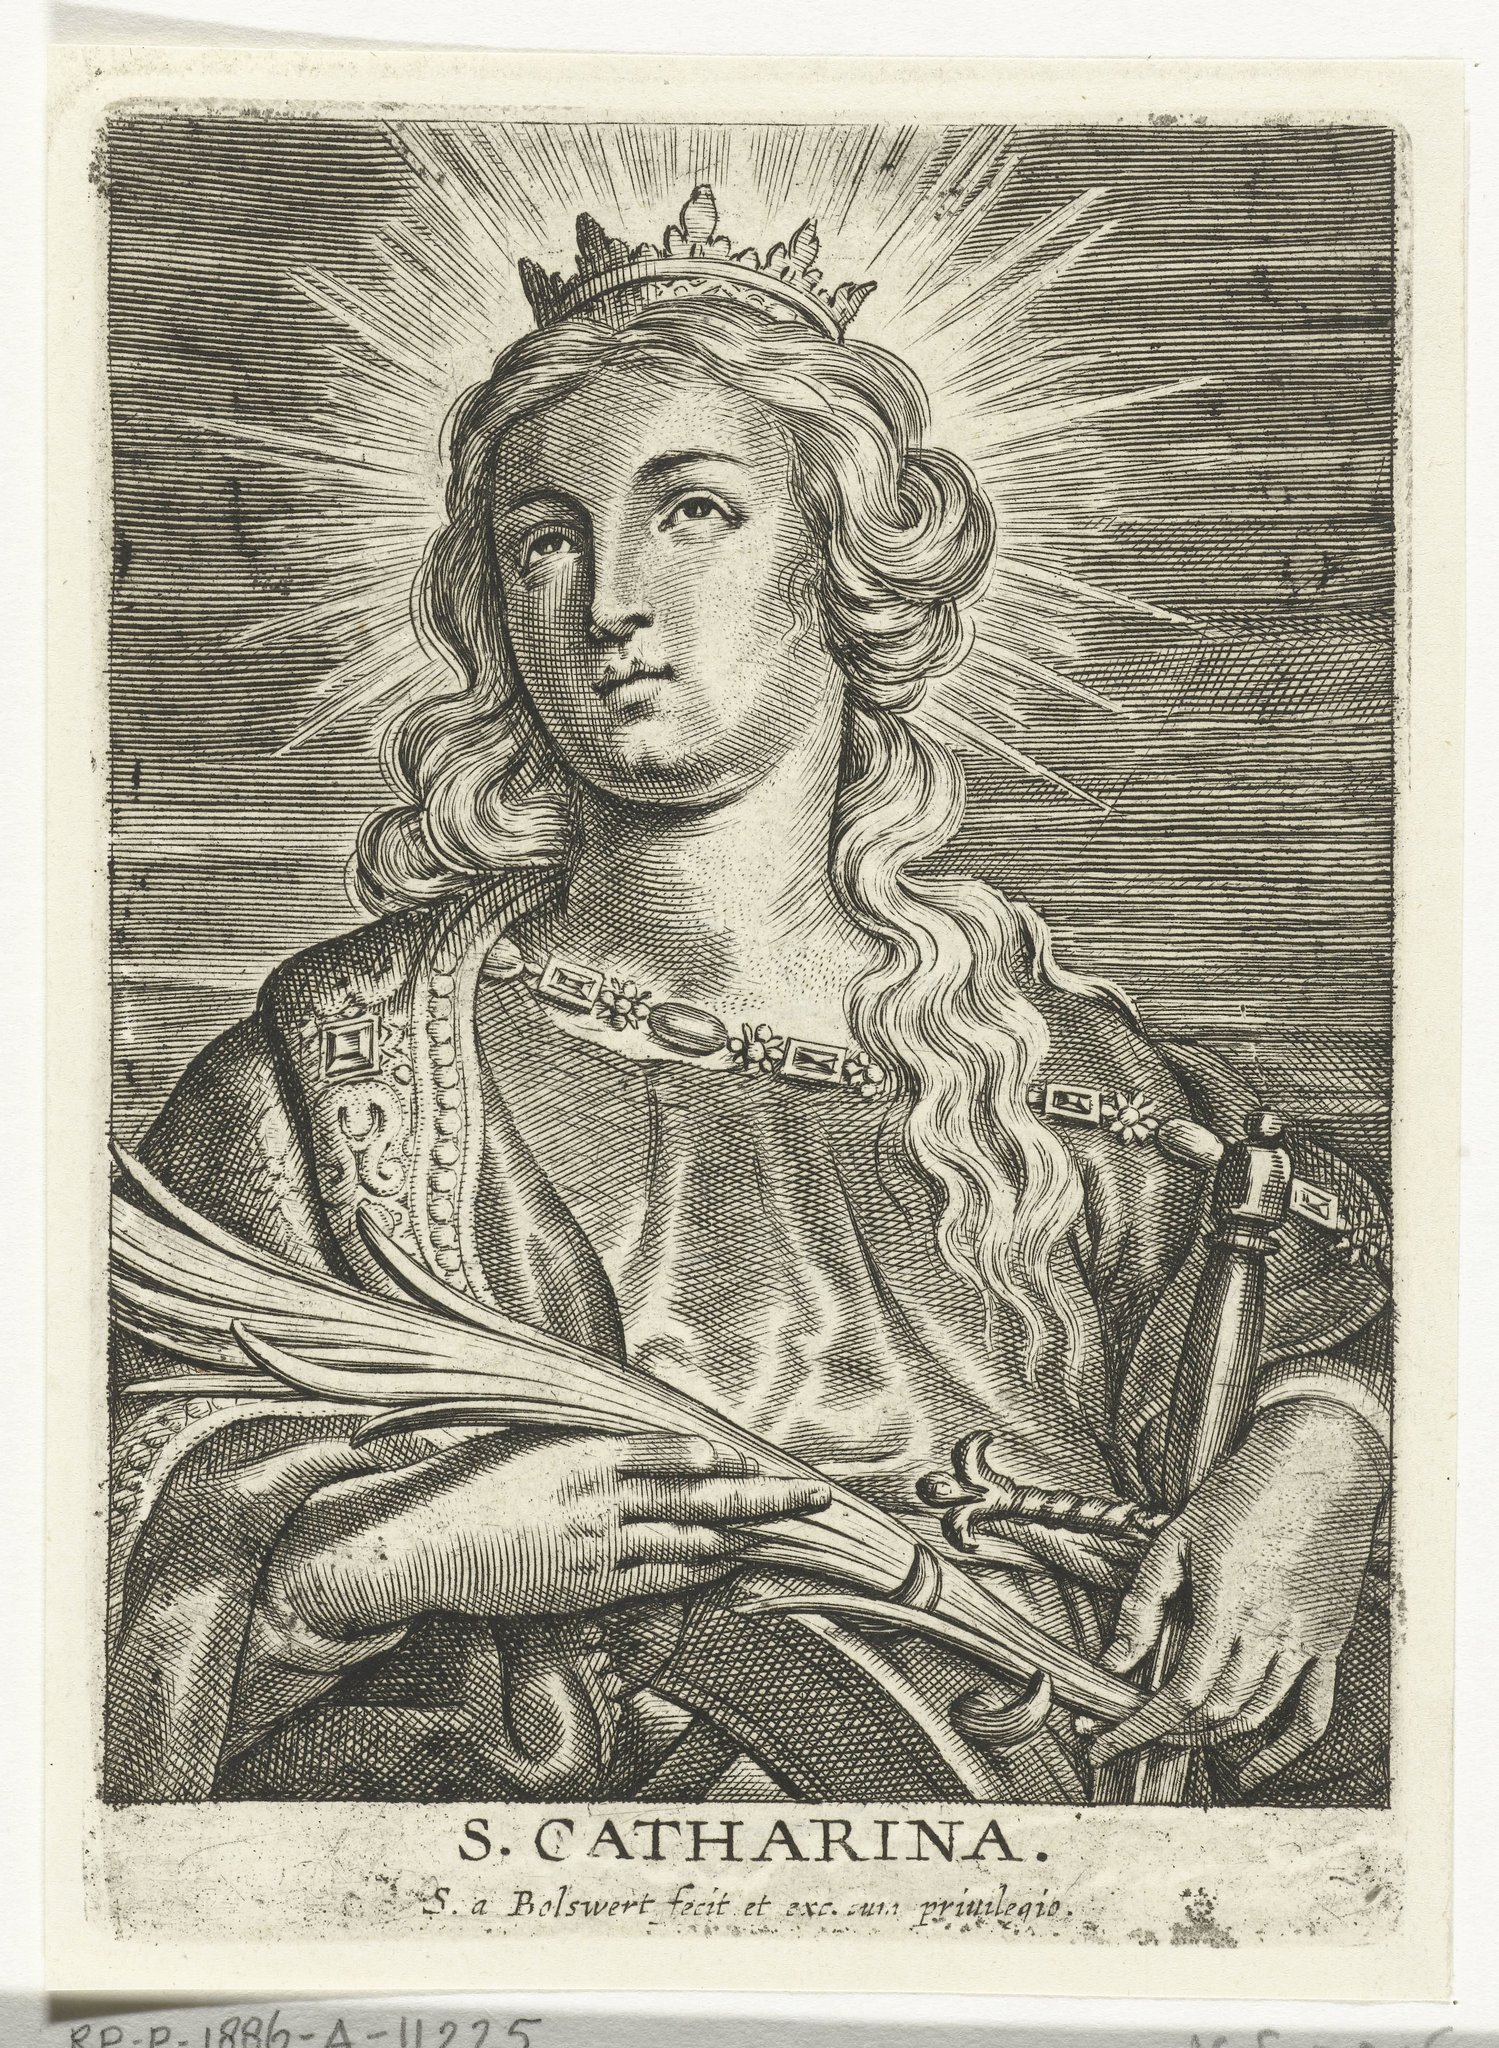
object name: print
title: S. Catharina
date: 1596-1659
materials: paper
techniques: engraving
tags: male saints (with name)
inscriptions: collector's mark: Lugt 2228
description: Prent naar ontwerp van Peter Paul Rubens.